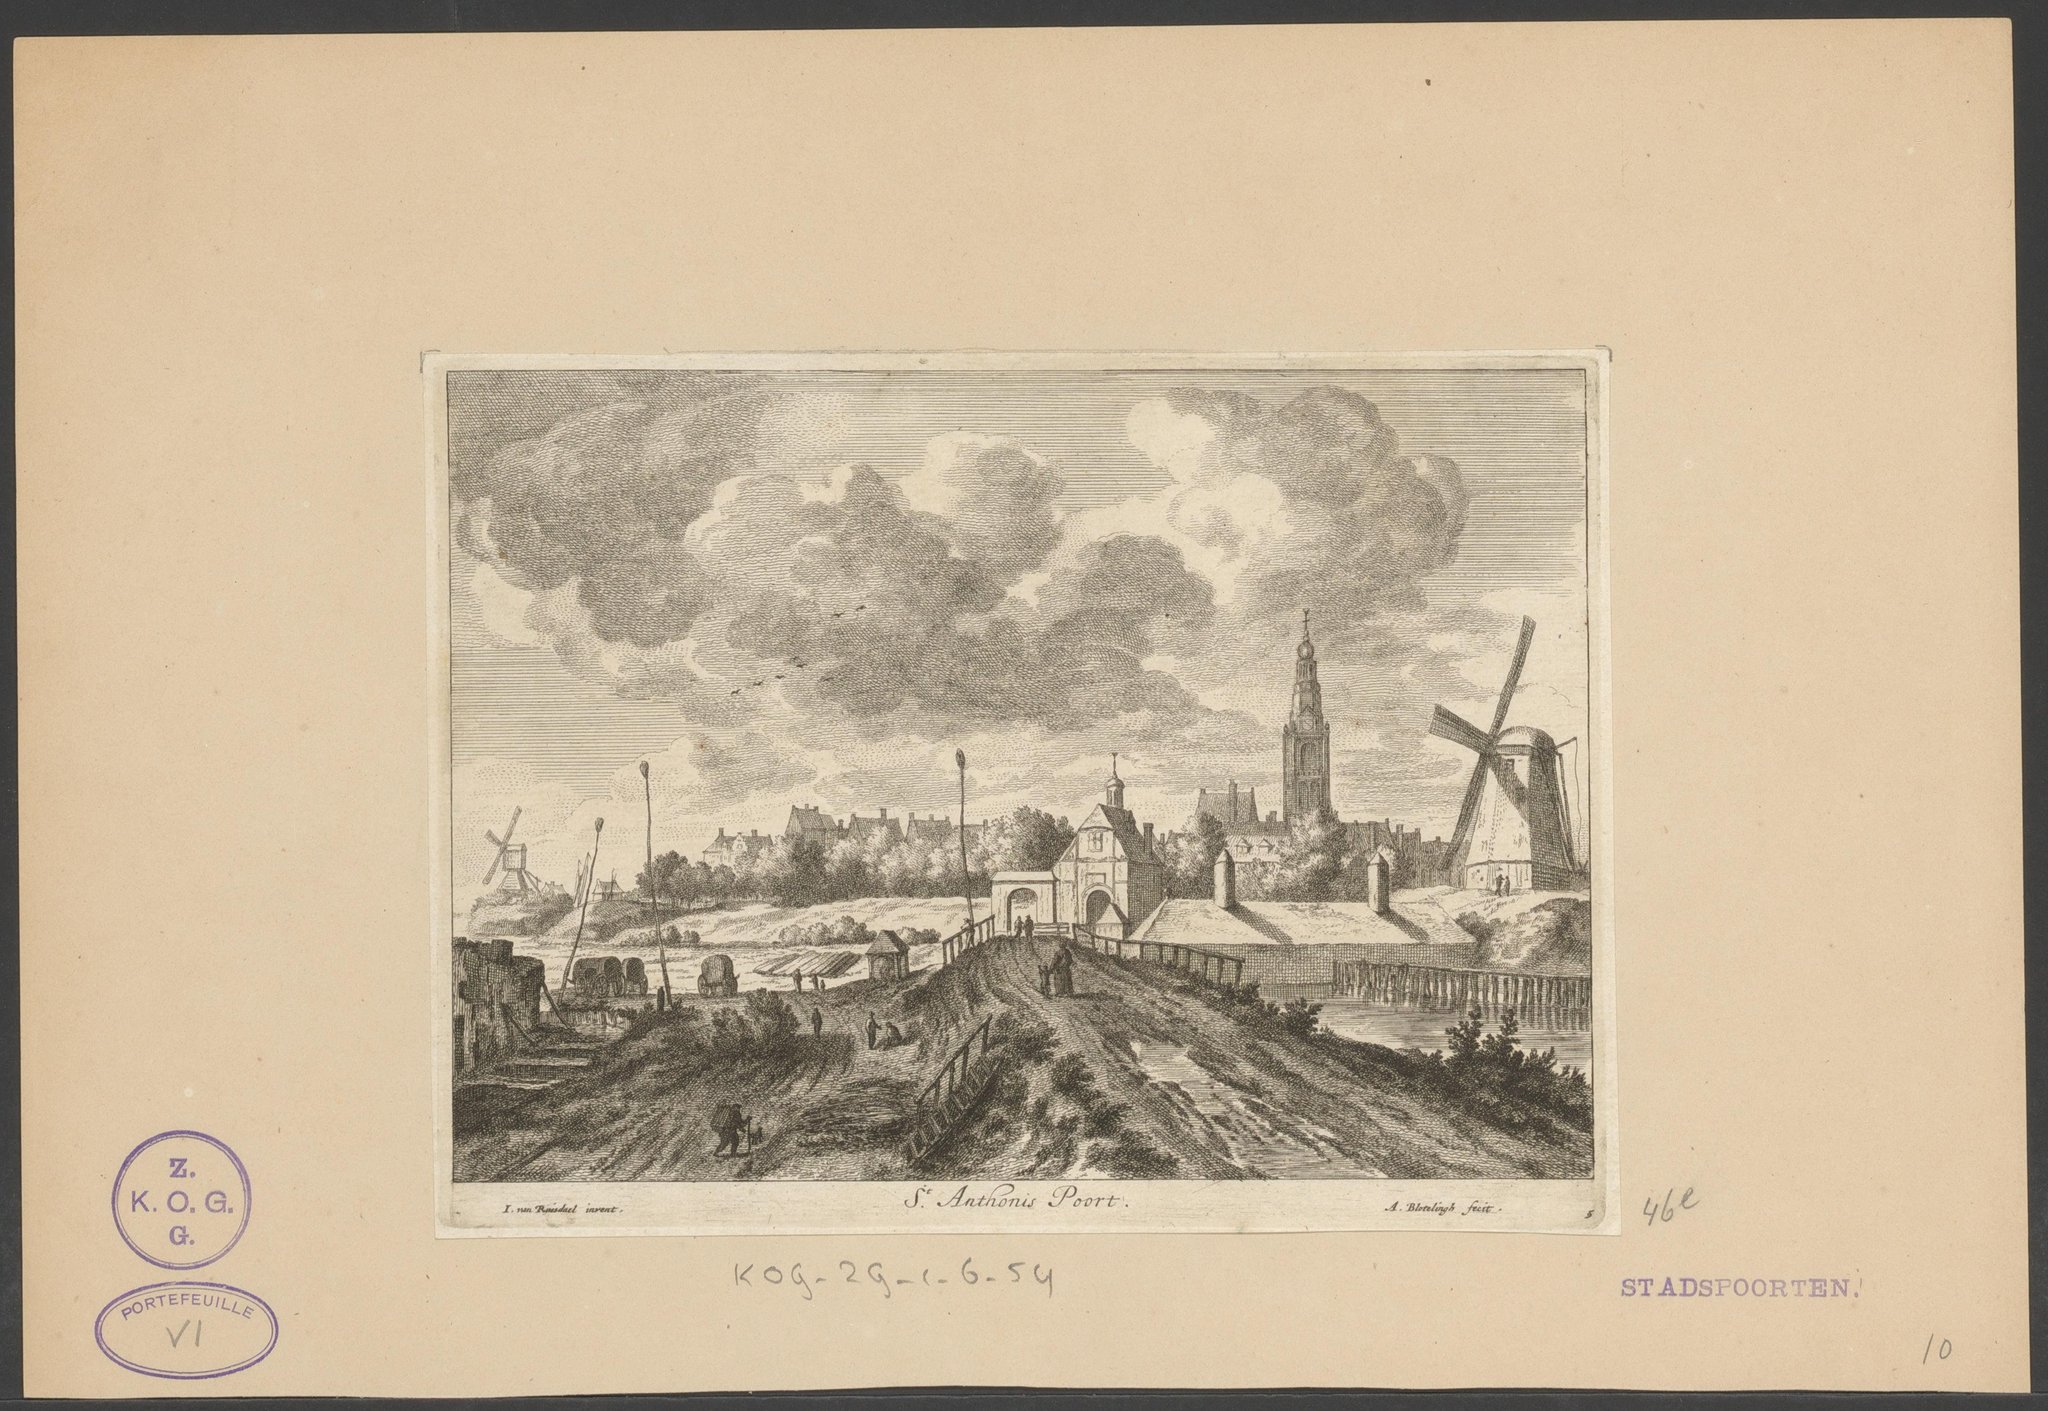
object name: print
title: Gezicht op de Eerste Sint-Antoniespoort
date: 1655-1690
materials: paper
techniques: engraving, etching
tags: tower, clock tower ~ monumental adornment, windmill, city-gate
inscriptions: collector's mark: Lugt 1641, stamp, stamp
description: Rechtsonder genummerd: 5. Onderwerpsrubrieken binnen de Atlas Zeden en Gewoonten: Krijgswezen, Stadspoorten.